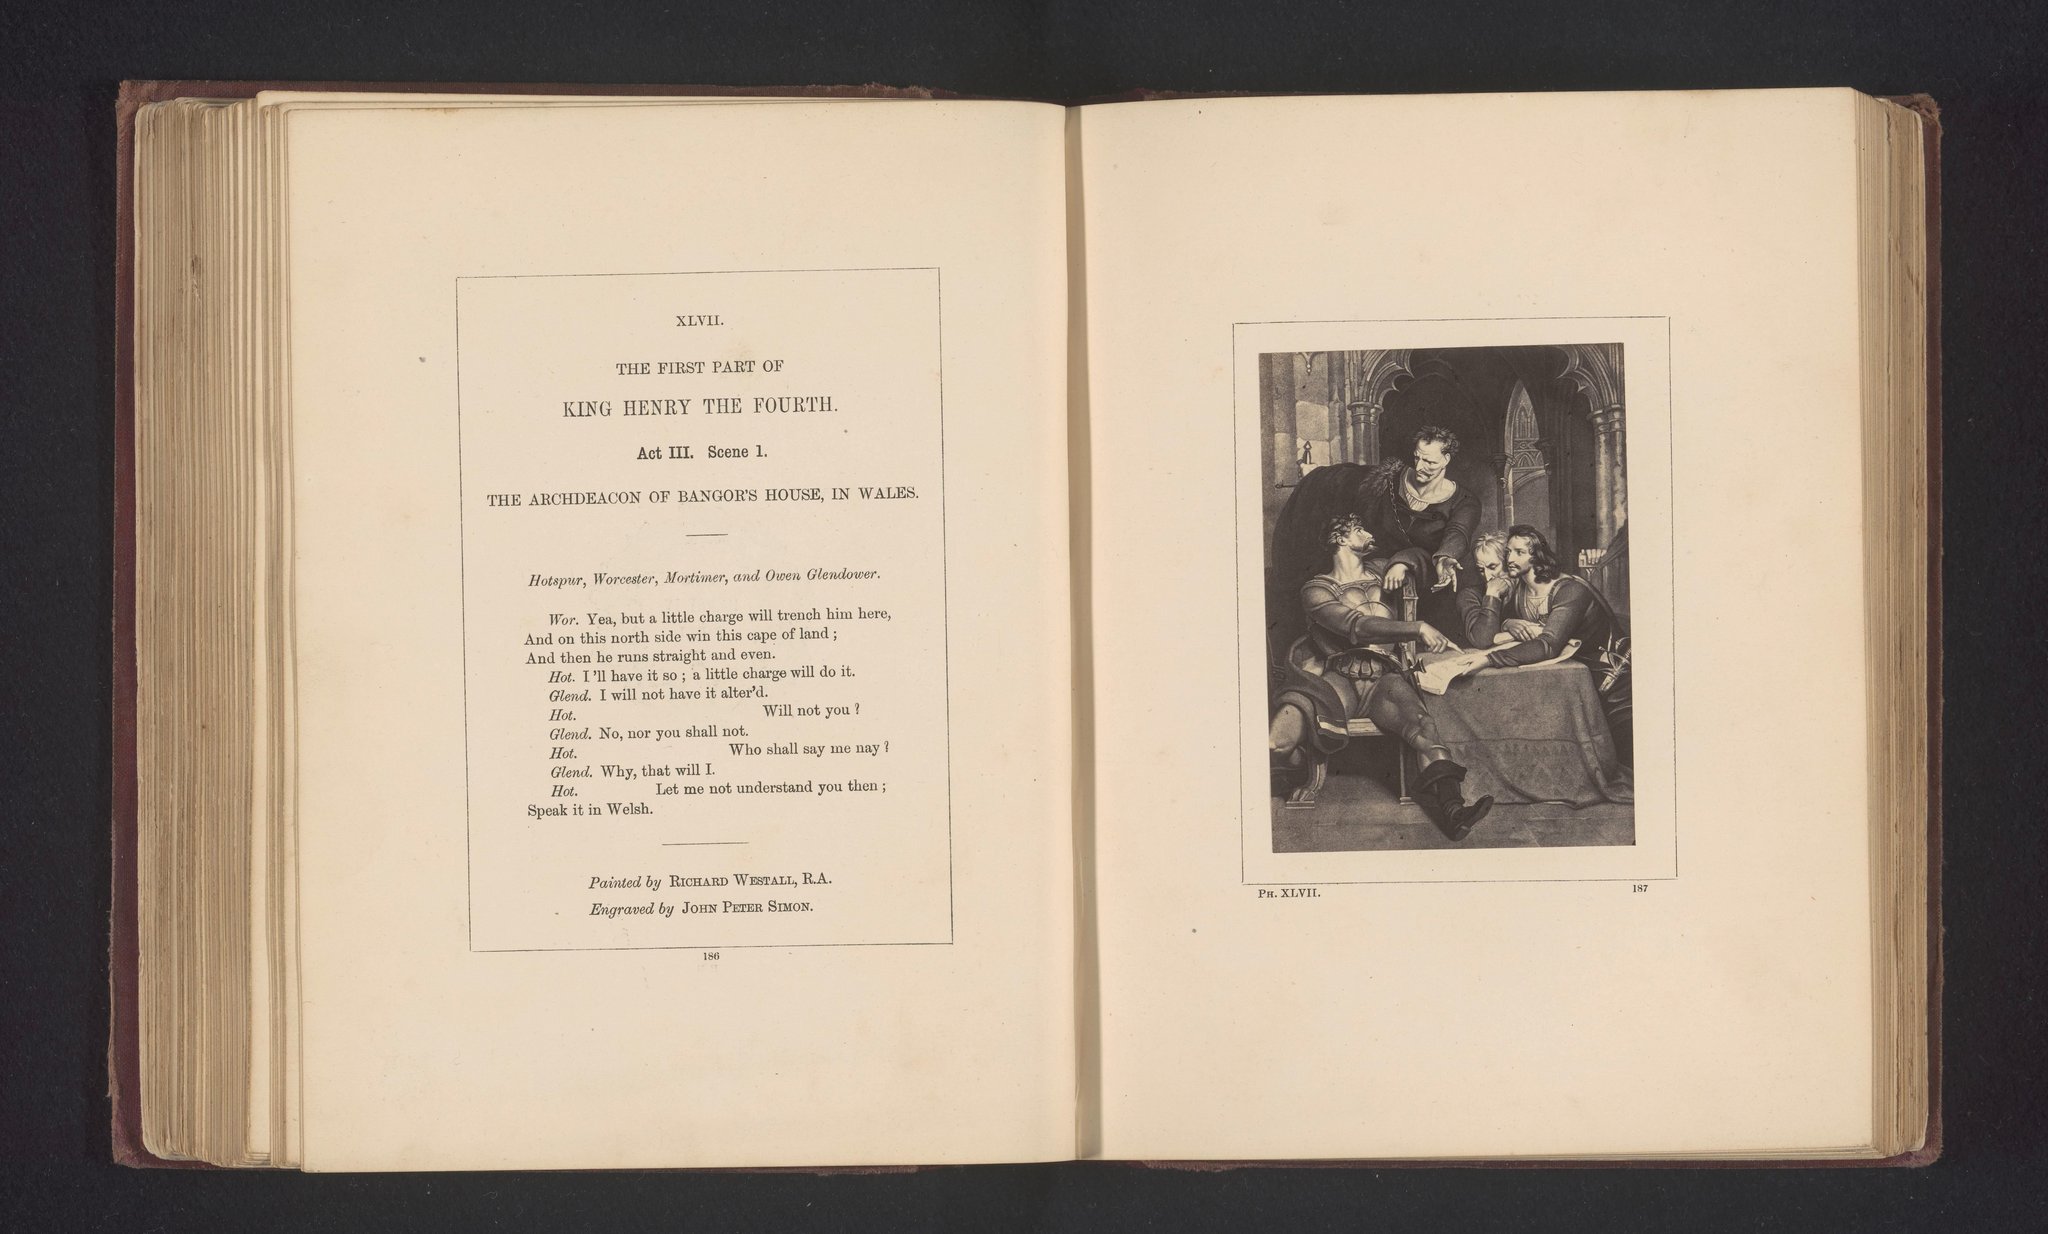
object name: photograph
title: Fotoreproductie van een prent naar een schilderij door Richard Westall, voorstellend een scene uit Hendrik IV door William Shakespeare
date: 1854-1867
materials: photographic support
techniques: albumen print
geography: london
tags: specific works of literature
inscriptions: number: ‘Ph. XLVII. 187’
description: Te zien is akte III, scene 1 met de graaf van Worcester, Lord Edmund Mortimer en anderen rond een tafel.